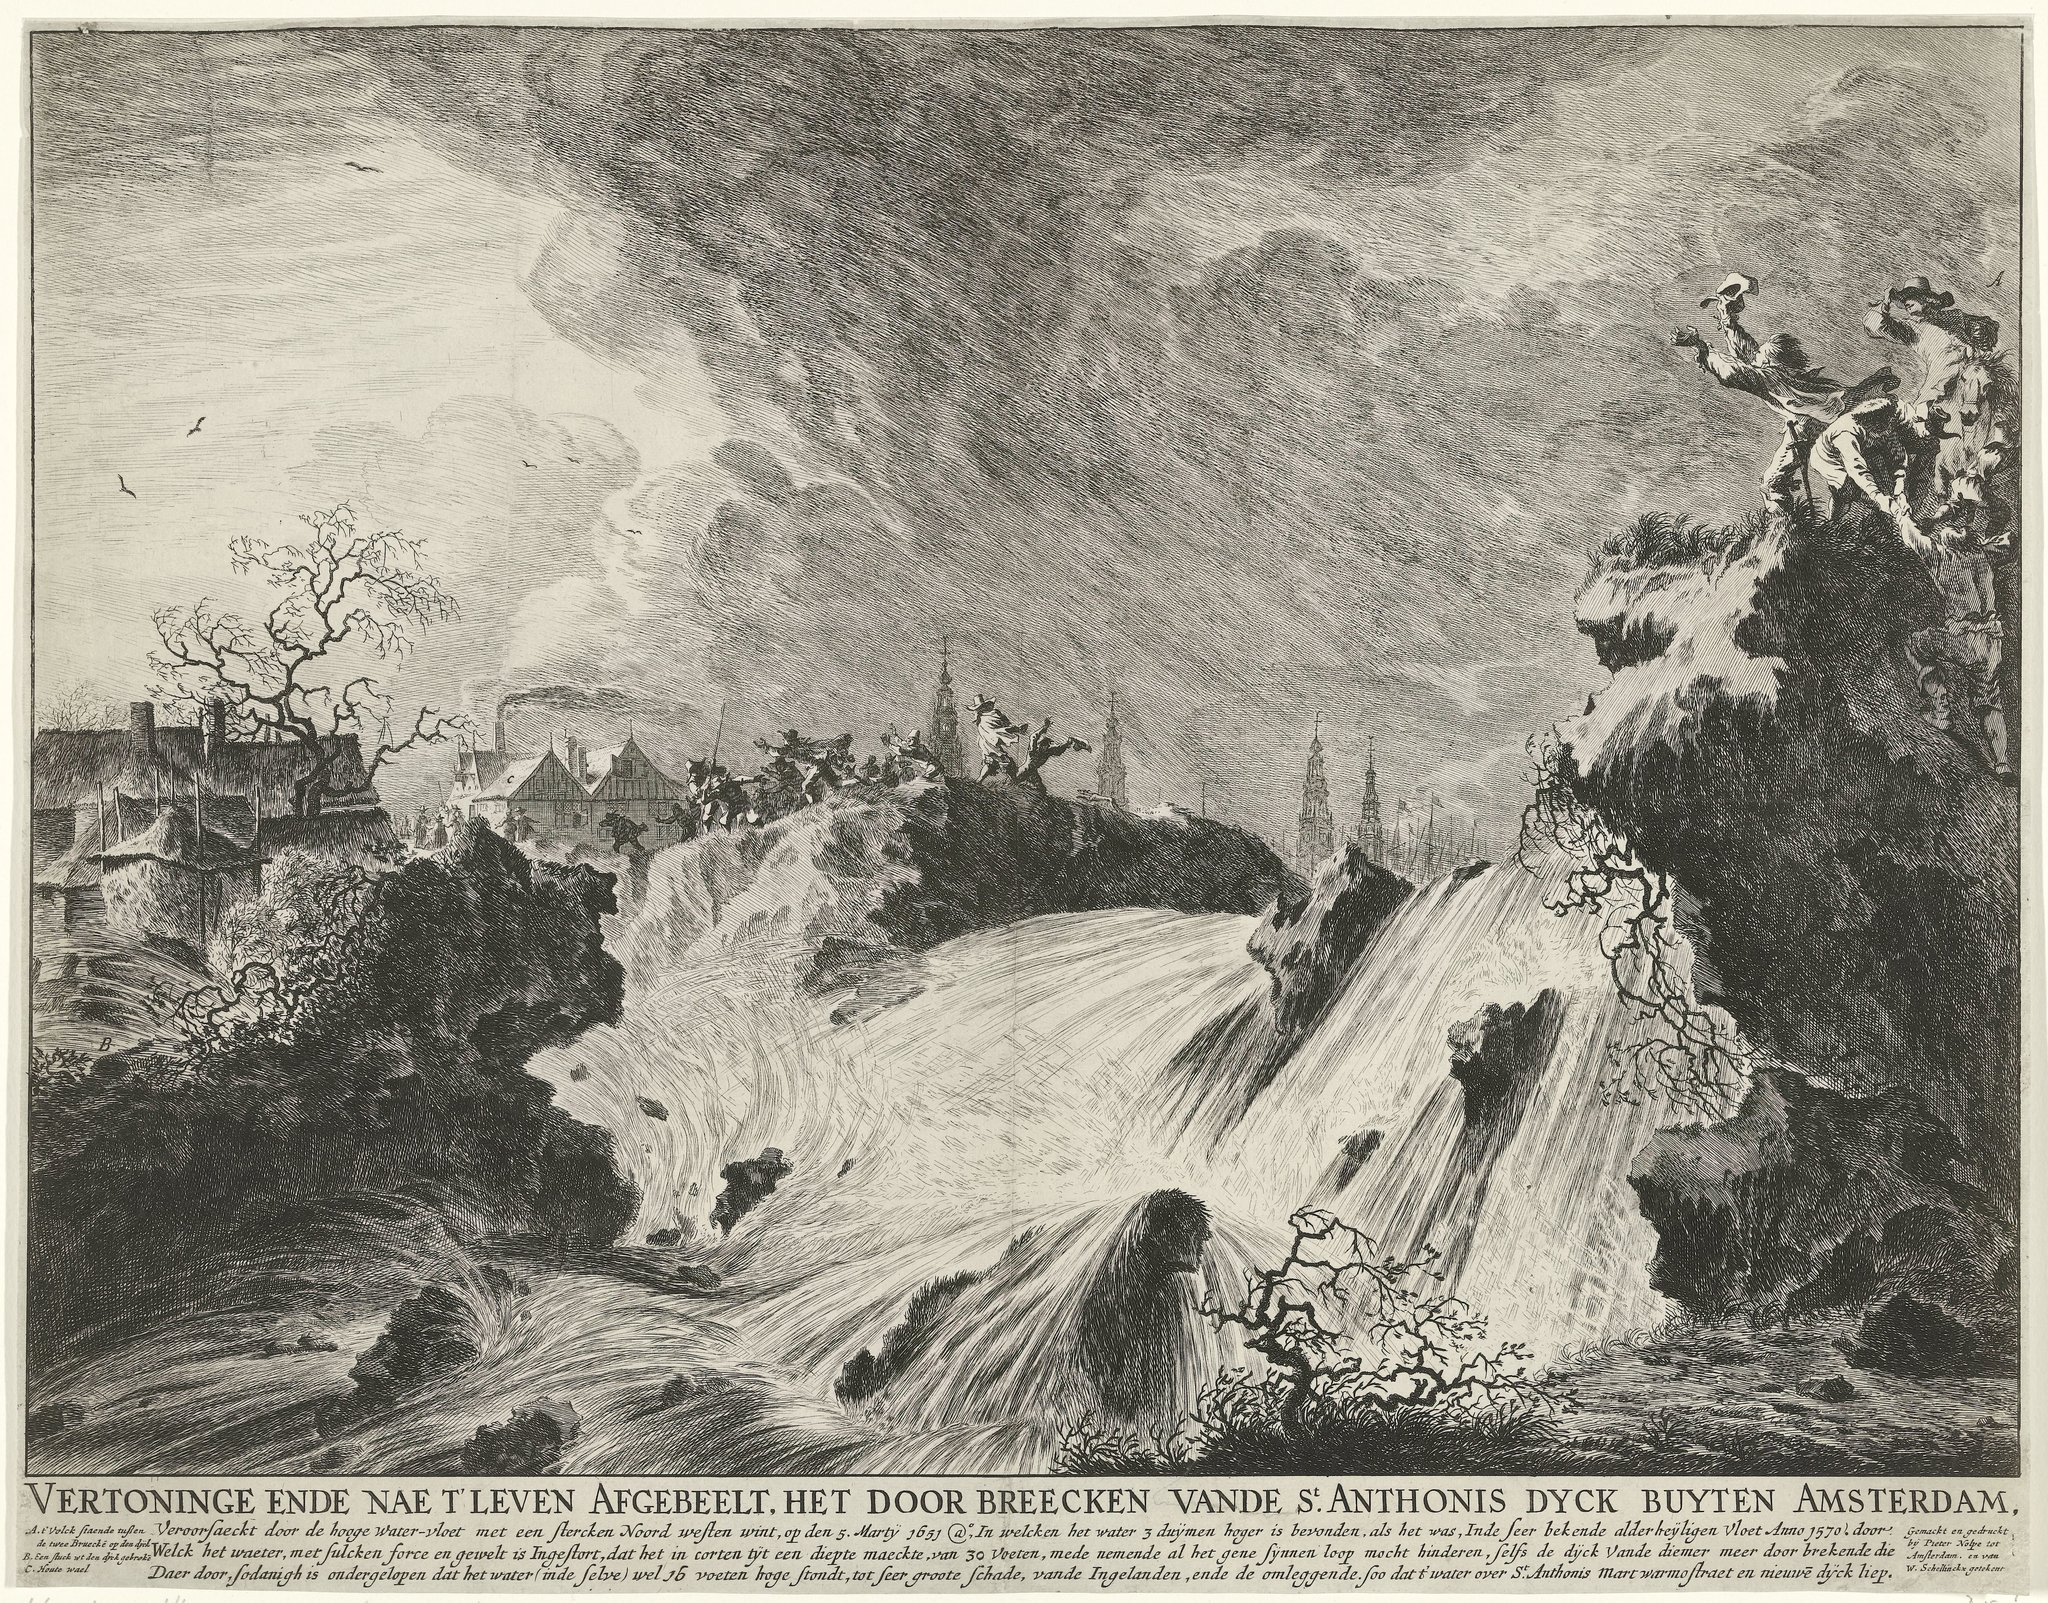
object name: print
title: Doorbraak van de Sint-Antoniesdijk op 5 maart 1651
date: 1651-1653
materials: paper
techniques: engraving, etching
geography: amsterdam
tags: dike-break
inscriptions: collector's mark: Lugt 2228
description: Dijkdoorbraak van de Sint-Antoniesdijk of Diemerzeedijk buiten Amsterdam op 5 maart 1651, veroorzaakt door de hoge watervloed en de sterke noordwester storm. Het water stroomt door het gat in de dijk, aan weerszijden van het gat toeschouwers in paniek. Op de achtergrond de torens van Amsterdam. Linksonder het eerste deel van de legenda A-C. Zie de bijbehorende plaat (FMH 2020).